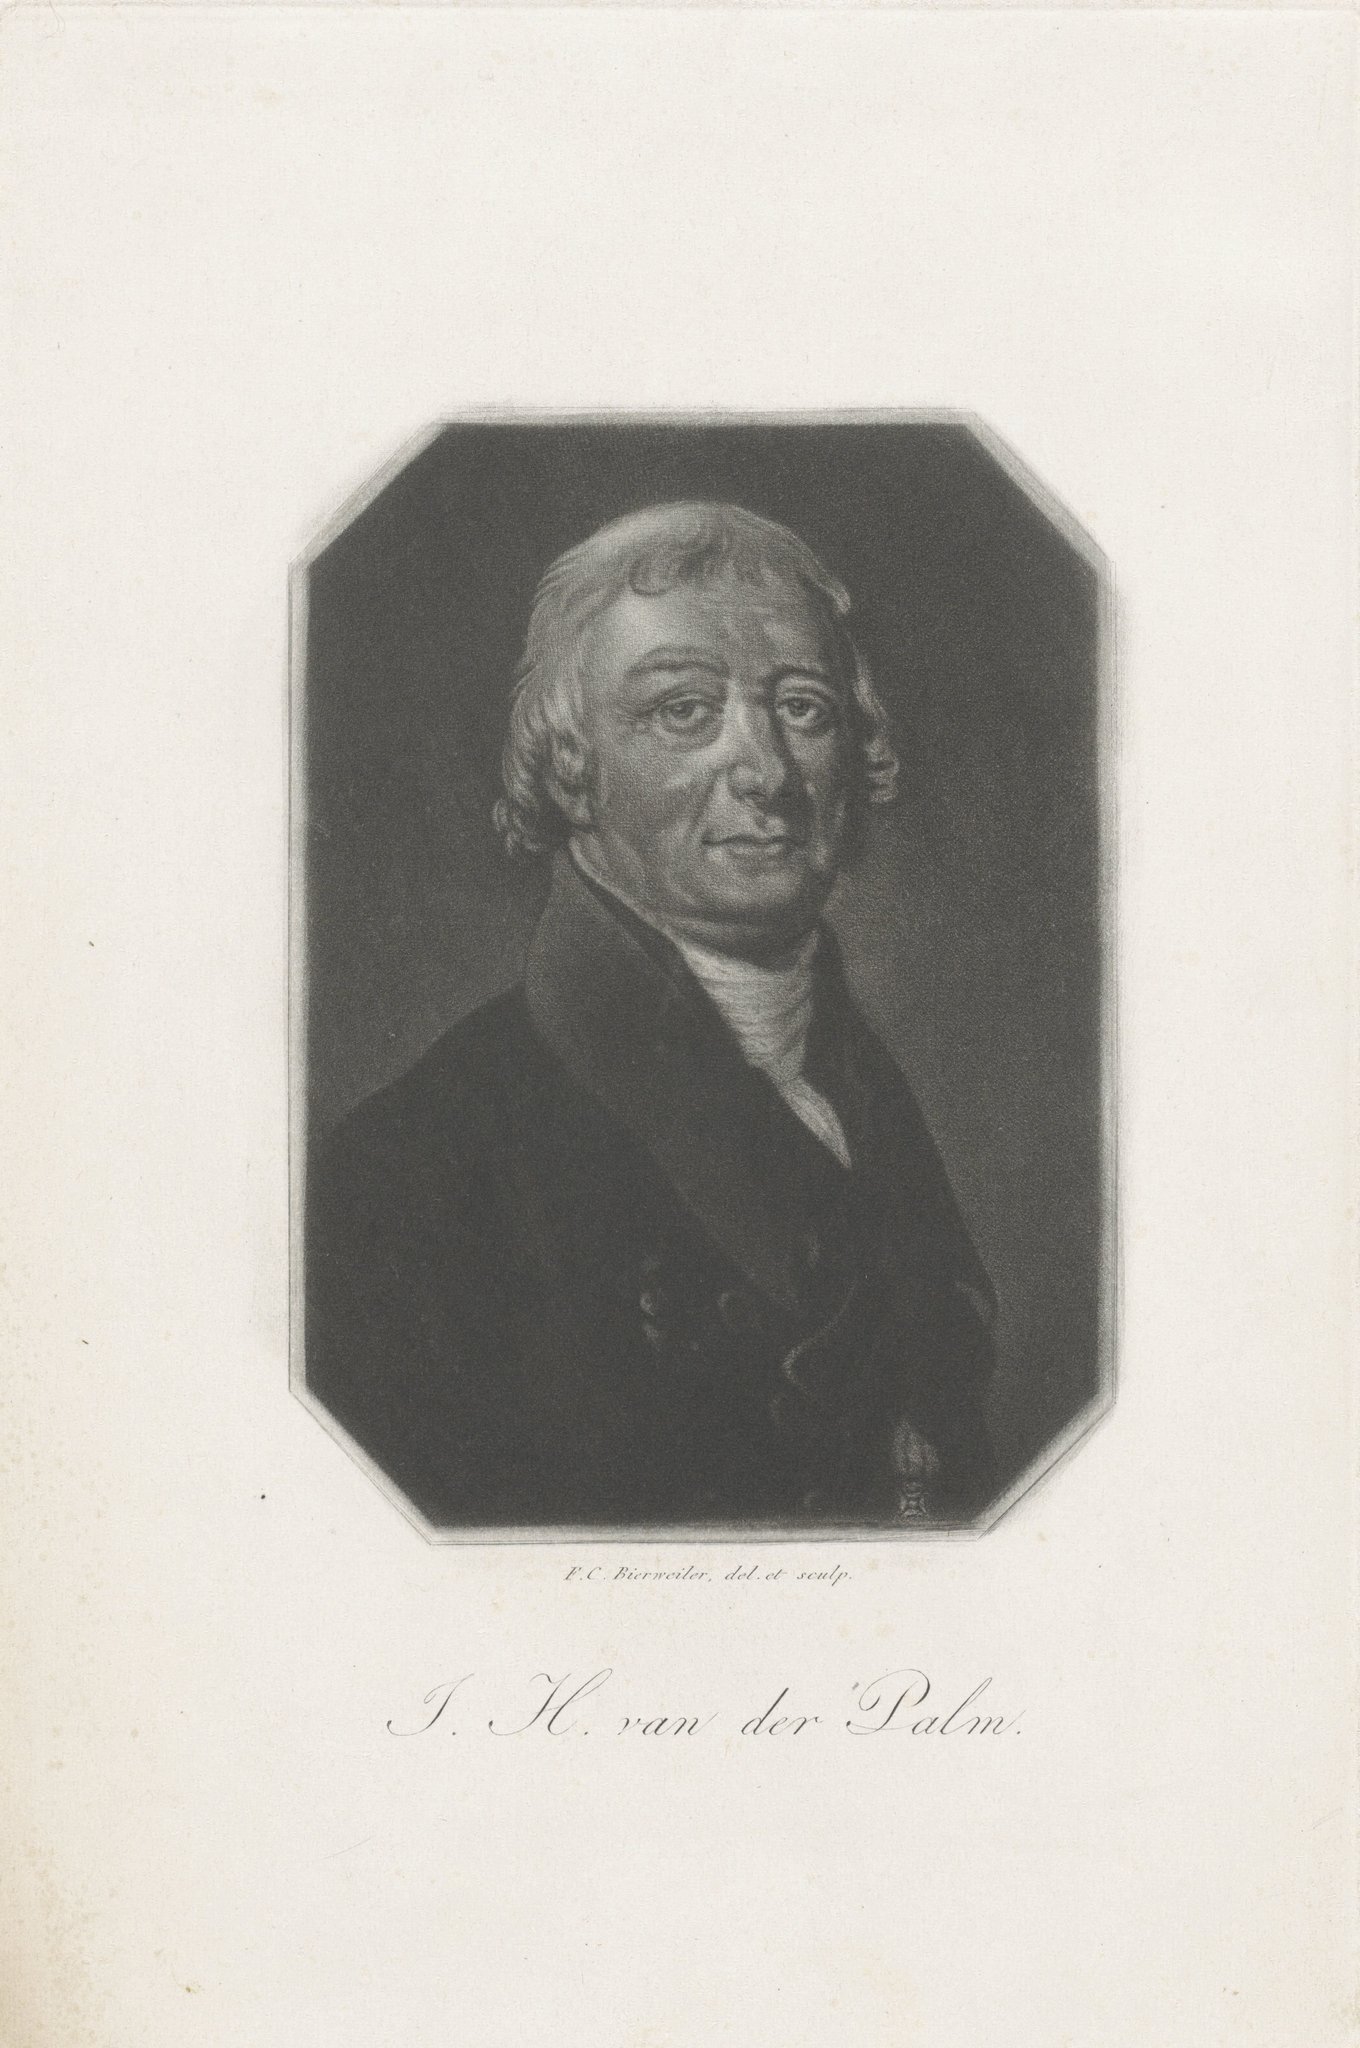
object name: print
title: Portret van Johannes Hendricus van der Palm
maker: frederik christiaan bierweiler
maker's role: print maker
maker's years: 1783-1831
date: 1826-1830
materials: paper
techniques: engraving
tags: leiden, johannes hendricus van der palm, historical persons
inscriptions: collector's mark: Lugt 2228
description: Johannes Hendricus van der Palm, predikant, theoloog en hoogleraar oosterse talen te Leiden. Op het revers een ridderorde.